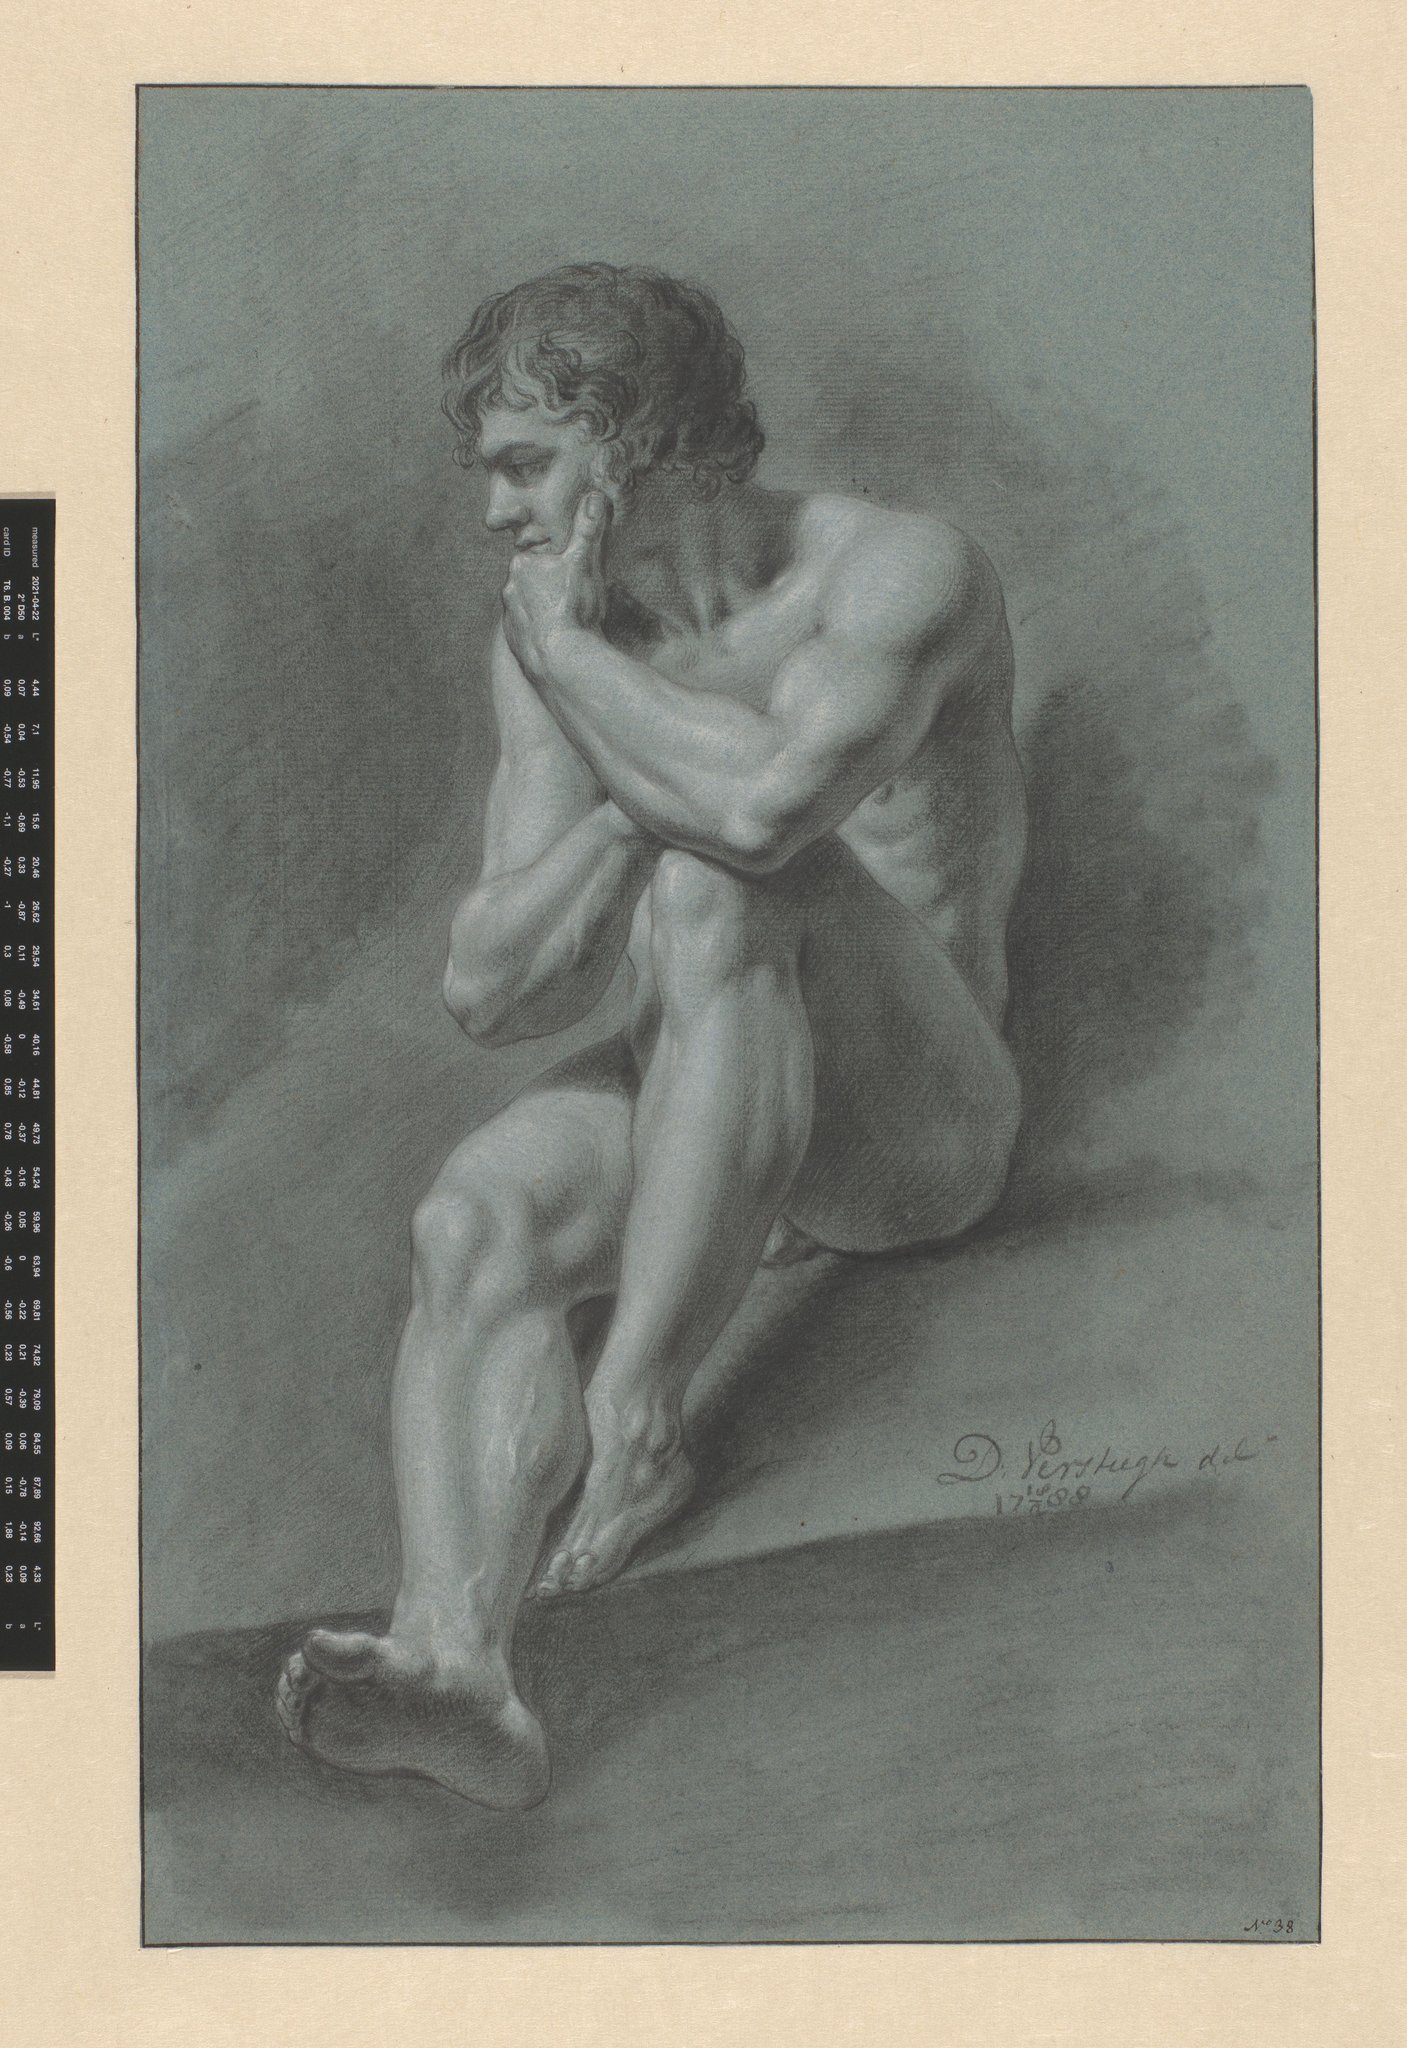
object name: drawing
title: Zittend mannelijk naakt met linkerhand onder de kin, naar links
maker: dirk versteegh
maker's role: draughtsman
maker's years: 1751-1822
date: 1788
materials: chalk, paper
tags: sitting on the ground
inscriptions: date